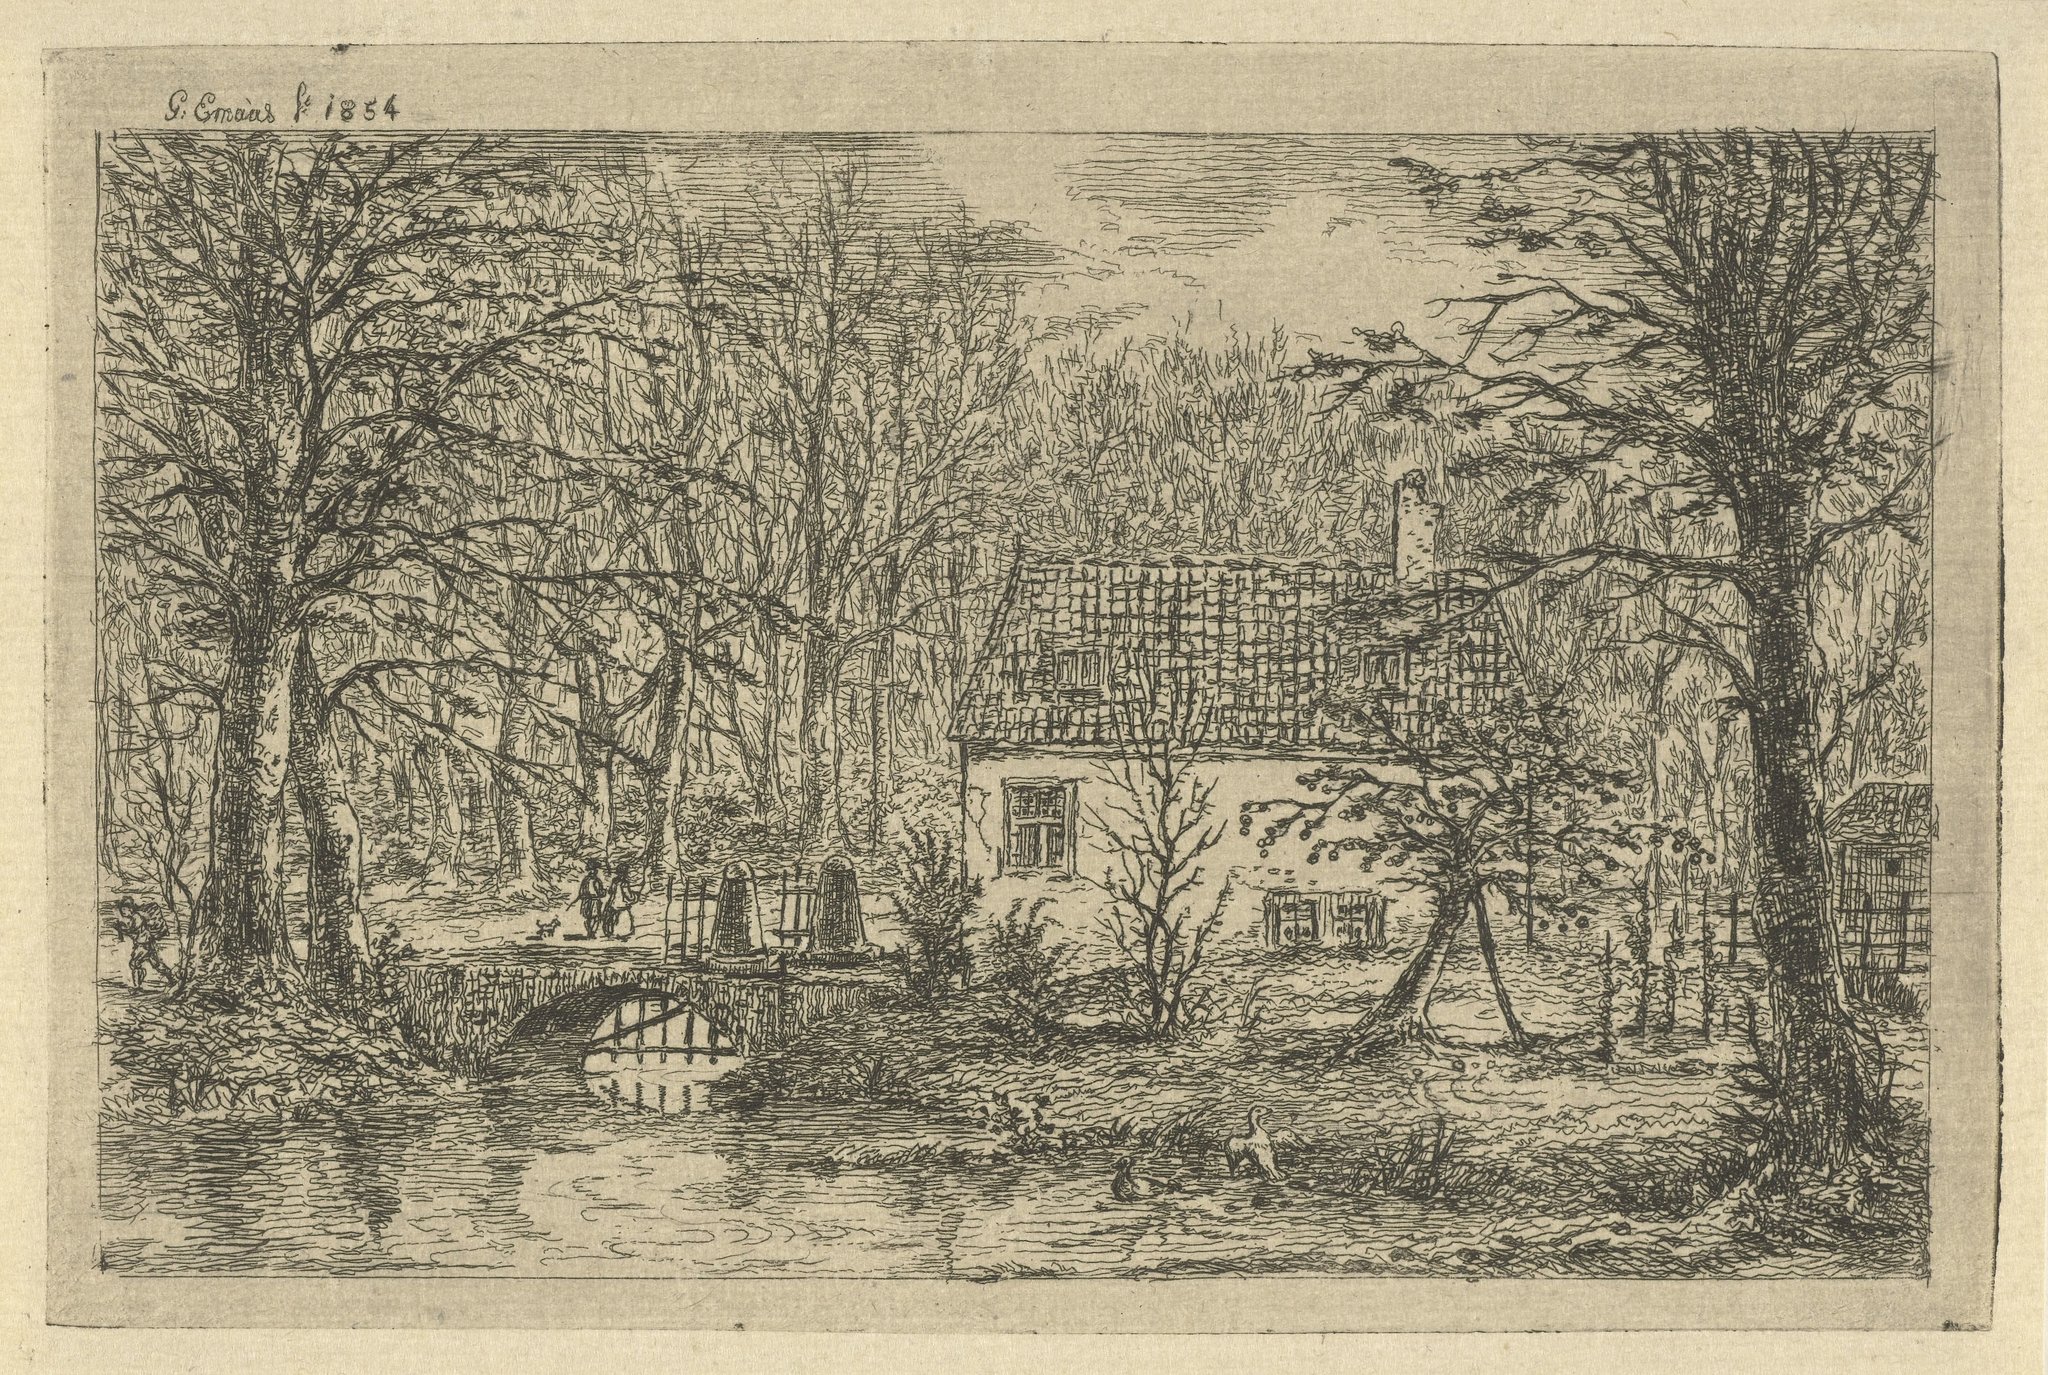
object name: print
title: Huis met brug over sloot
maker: gerardus emaus de micault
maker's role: draughtsman, print maker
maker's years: 1798-1863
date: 1854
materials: paper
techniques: etching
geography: netherlands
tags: farm or solitary house in landscape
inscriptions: collector's mark: Lugt 2228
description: Gezicht op een huis tussen hoge bomen. Over de sloot loopt een brug en op de achtergrond, nabij een bos staan twee mensen met een hond.